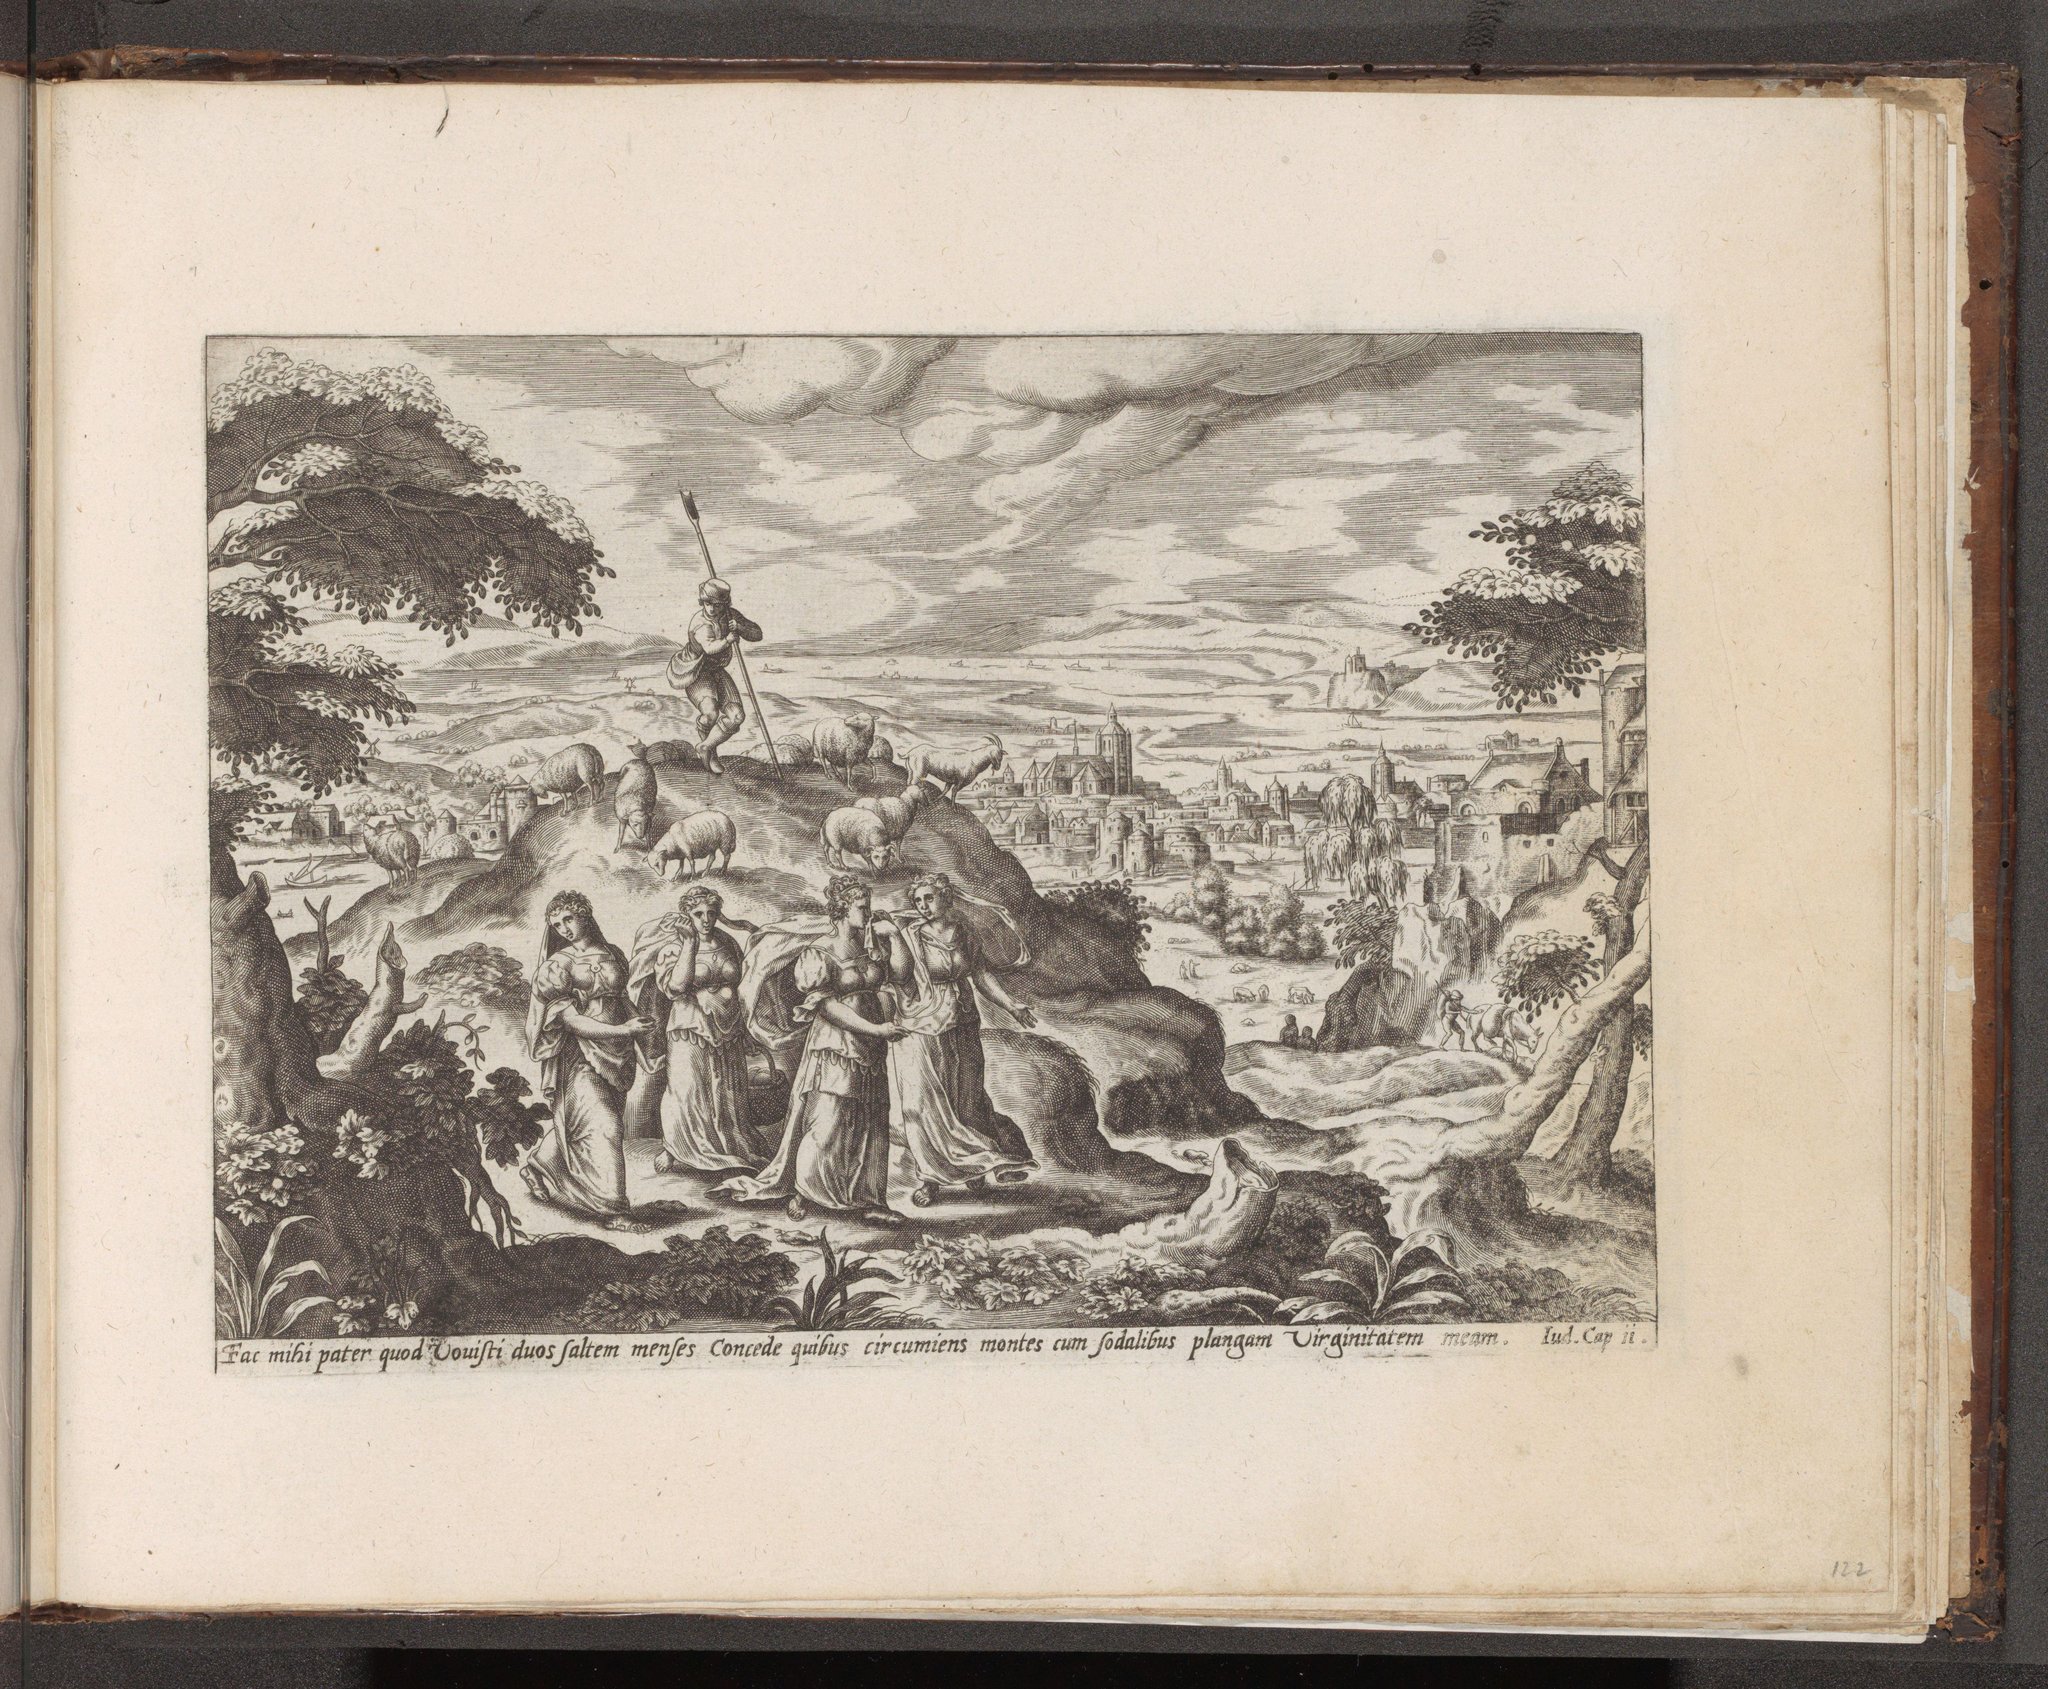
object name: print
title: Jefta's dochter treurt met haar vriendinnen in de bergen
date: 1579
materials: paper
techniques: engraving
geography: antwerp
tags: jephthah's daughter retreats to the mountains with her companions to bewail her virginity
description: Jefta´s dochter trekt zich terug in de bergen om met haar vriendinnen om haar maagdelijkheid te treuren. Achter hen staat een herder met zijn schapen op een berg. Op de achtergrond een stad. Onder de voorstelling een verwijzing in het Latijn naar de Bijbeltekst in Ri. 11. Prent maakt deel uit van een album.